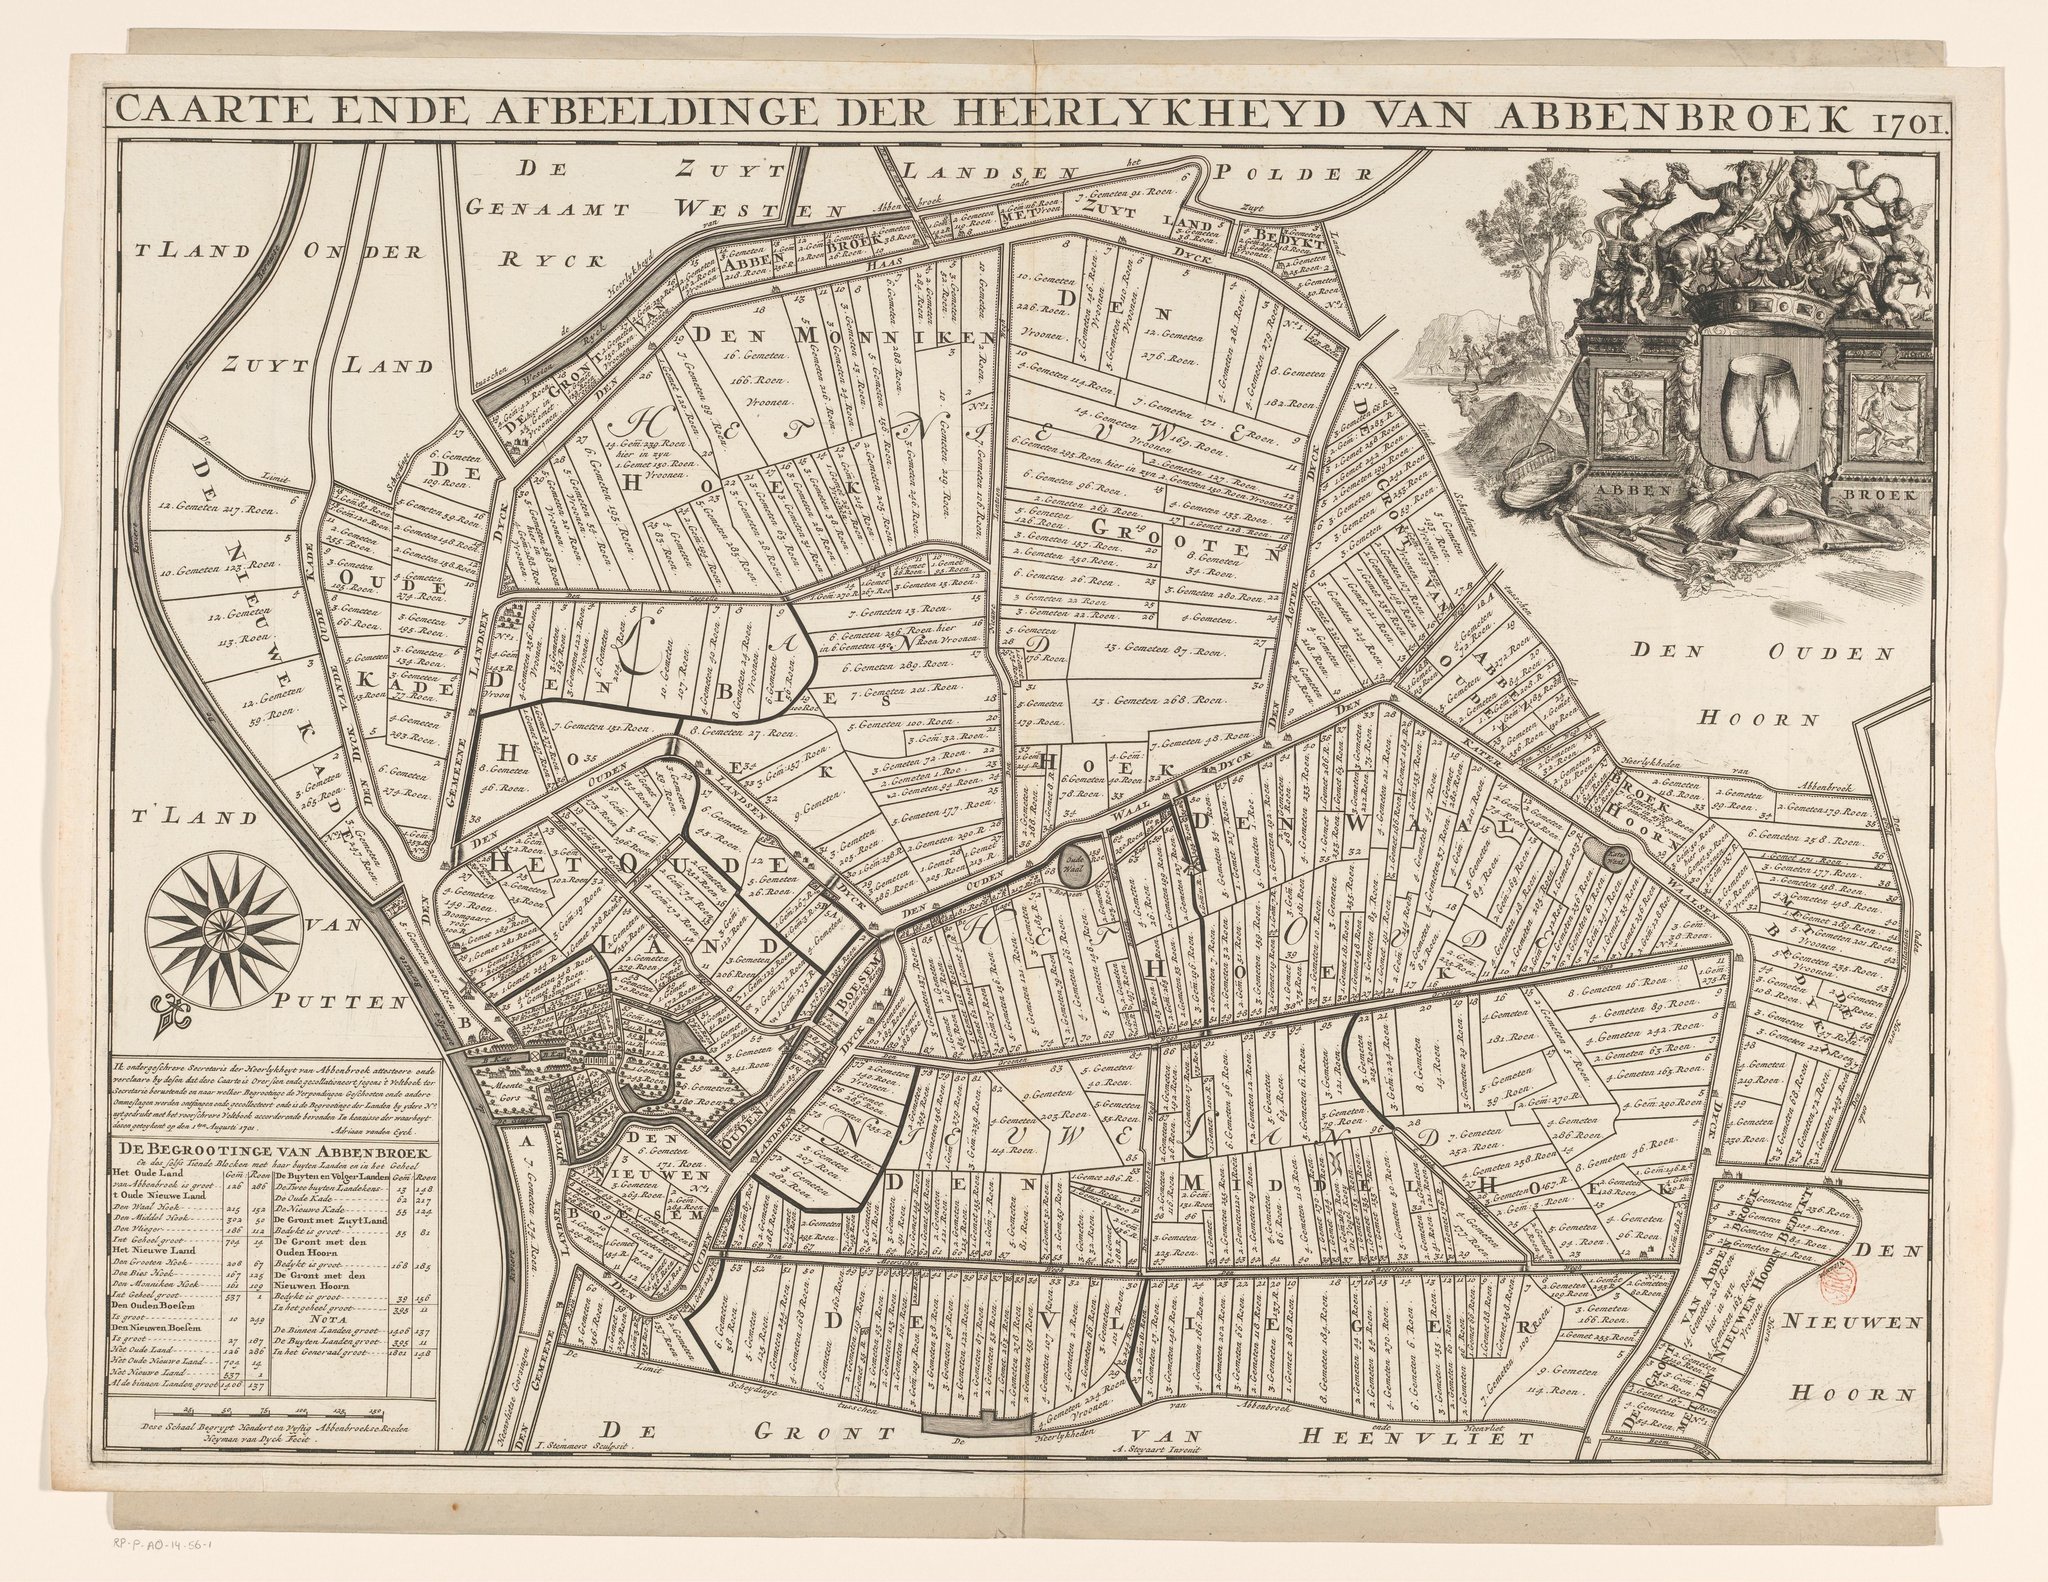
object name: map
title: Caarte ende afbeeldinge der heerlykheyd van Abbenbroek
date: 1701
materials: paper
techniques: engraving, etching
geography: amsterdam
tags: coat of arms (as symbol of the state, etc.), maps of separate countries or regions, hunting, chase, agriculture, polder, reclaimed land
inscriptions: collector's mark: Lugt 195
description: Deze kaart is onderdeel van het zogenaamde 'Voorne Caart-boeck' / 'Caartboeck van Voorne', dat bestaat uit een titelpagina (zie RP-P-1942-347), drie algemene kaarten (van Oost-, West- en Zuid-Voorne)* en dertig detailkaarten. Het kaartboek werd vervaardigd in opdracht van de Staten van Voorne en werd in 1701 uitgegeven. Een deel van de koperplaten is bewaard gebleven en in de negentiende en twintigste eeuw gebruikt voor herdrukken. *Over de naam Voorne kan verwarring ontstaan omdat de betekenis door de eeuwen heen is veranderd. Vroeger stonden de (voormalige) eilanden Voorne, Goeree en Overflakkee – allen historisch gezien onderdeel van het Land van Voorne – bekend als respectievelijk Oost-, West- en Zuid-Voorne.